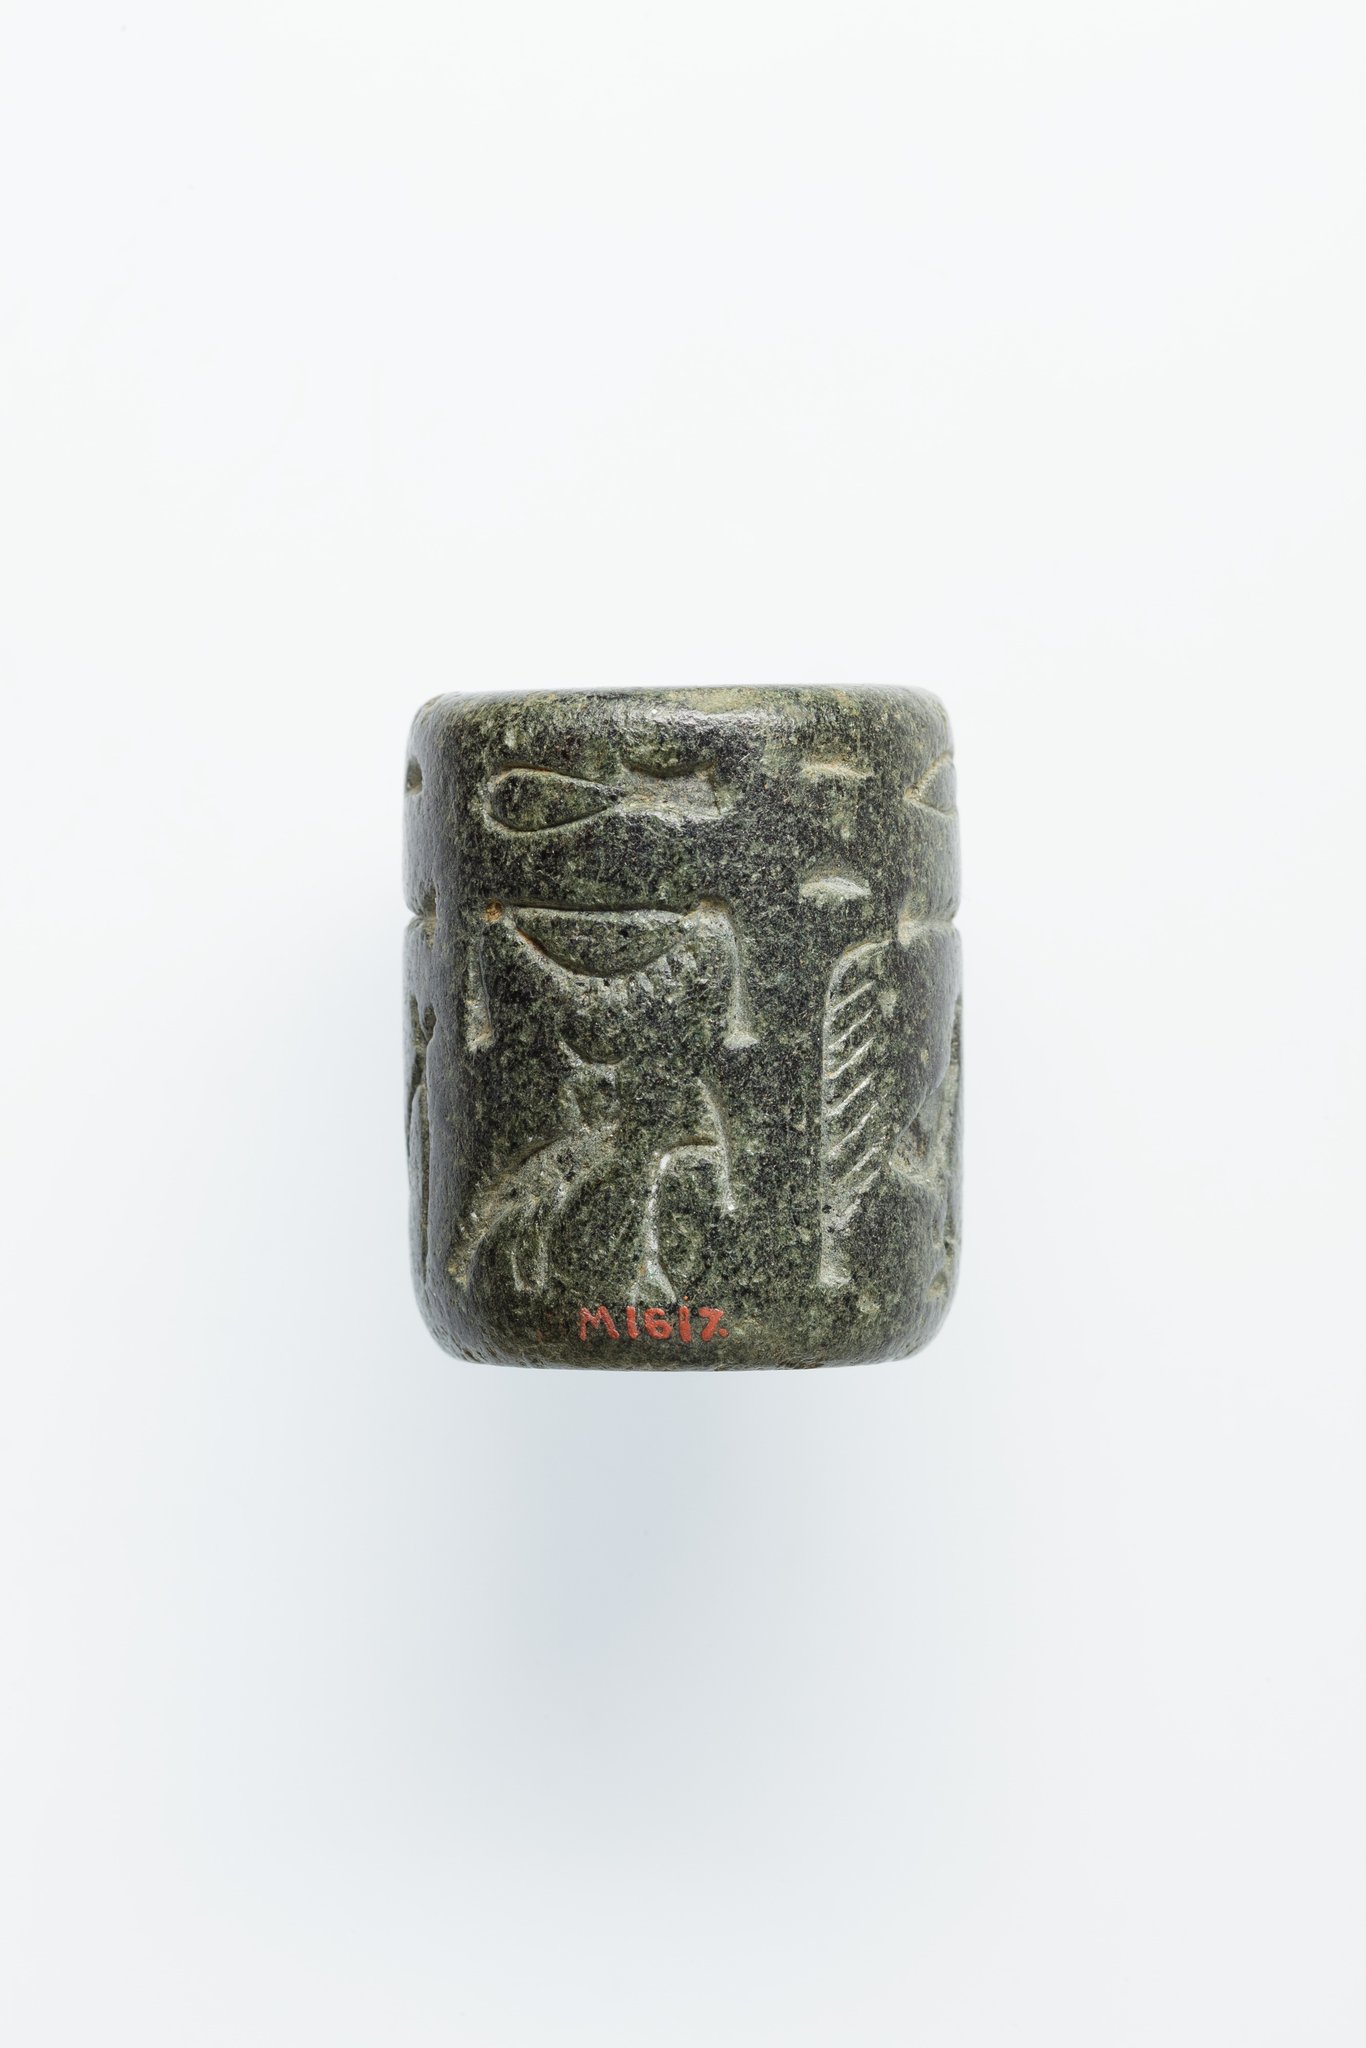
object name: cylinder seal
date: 2649-2100 BCE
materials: stone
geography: egypt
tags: hieroglyphs